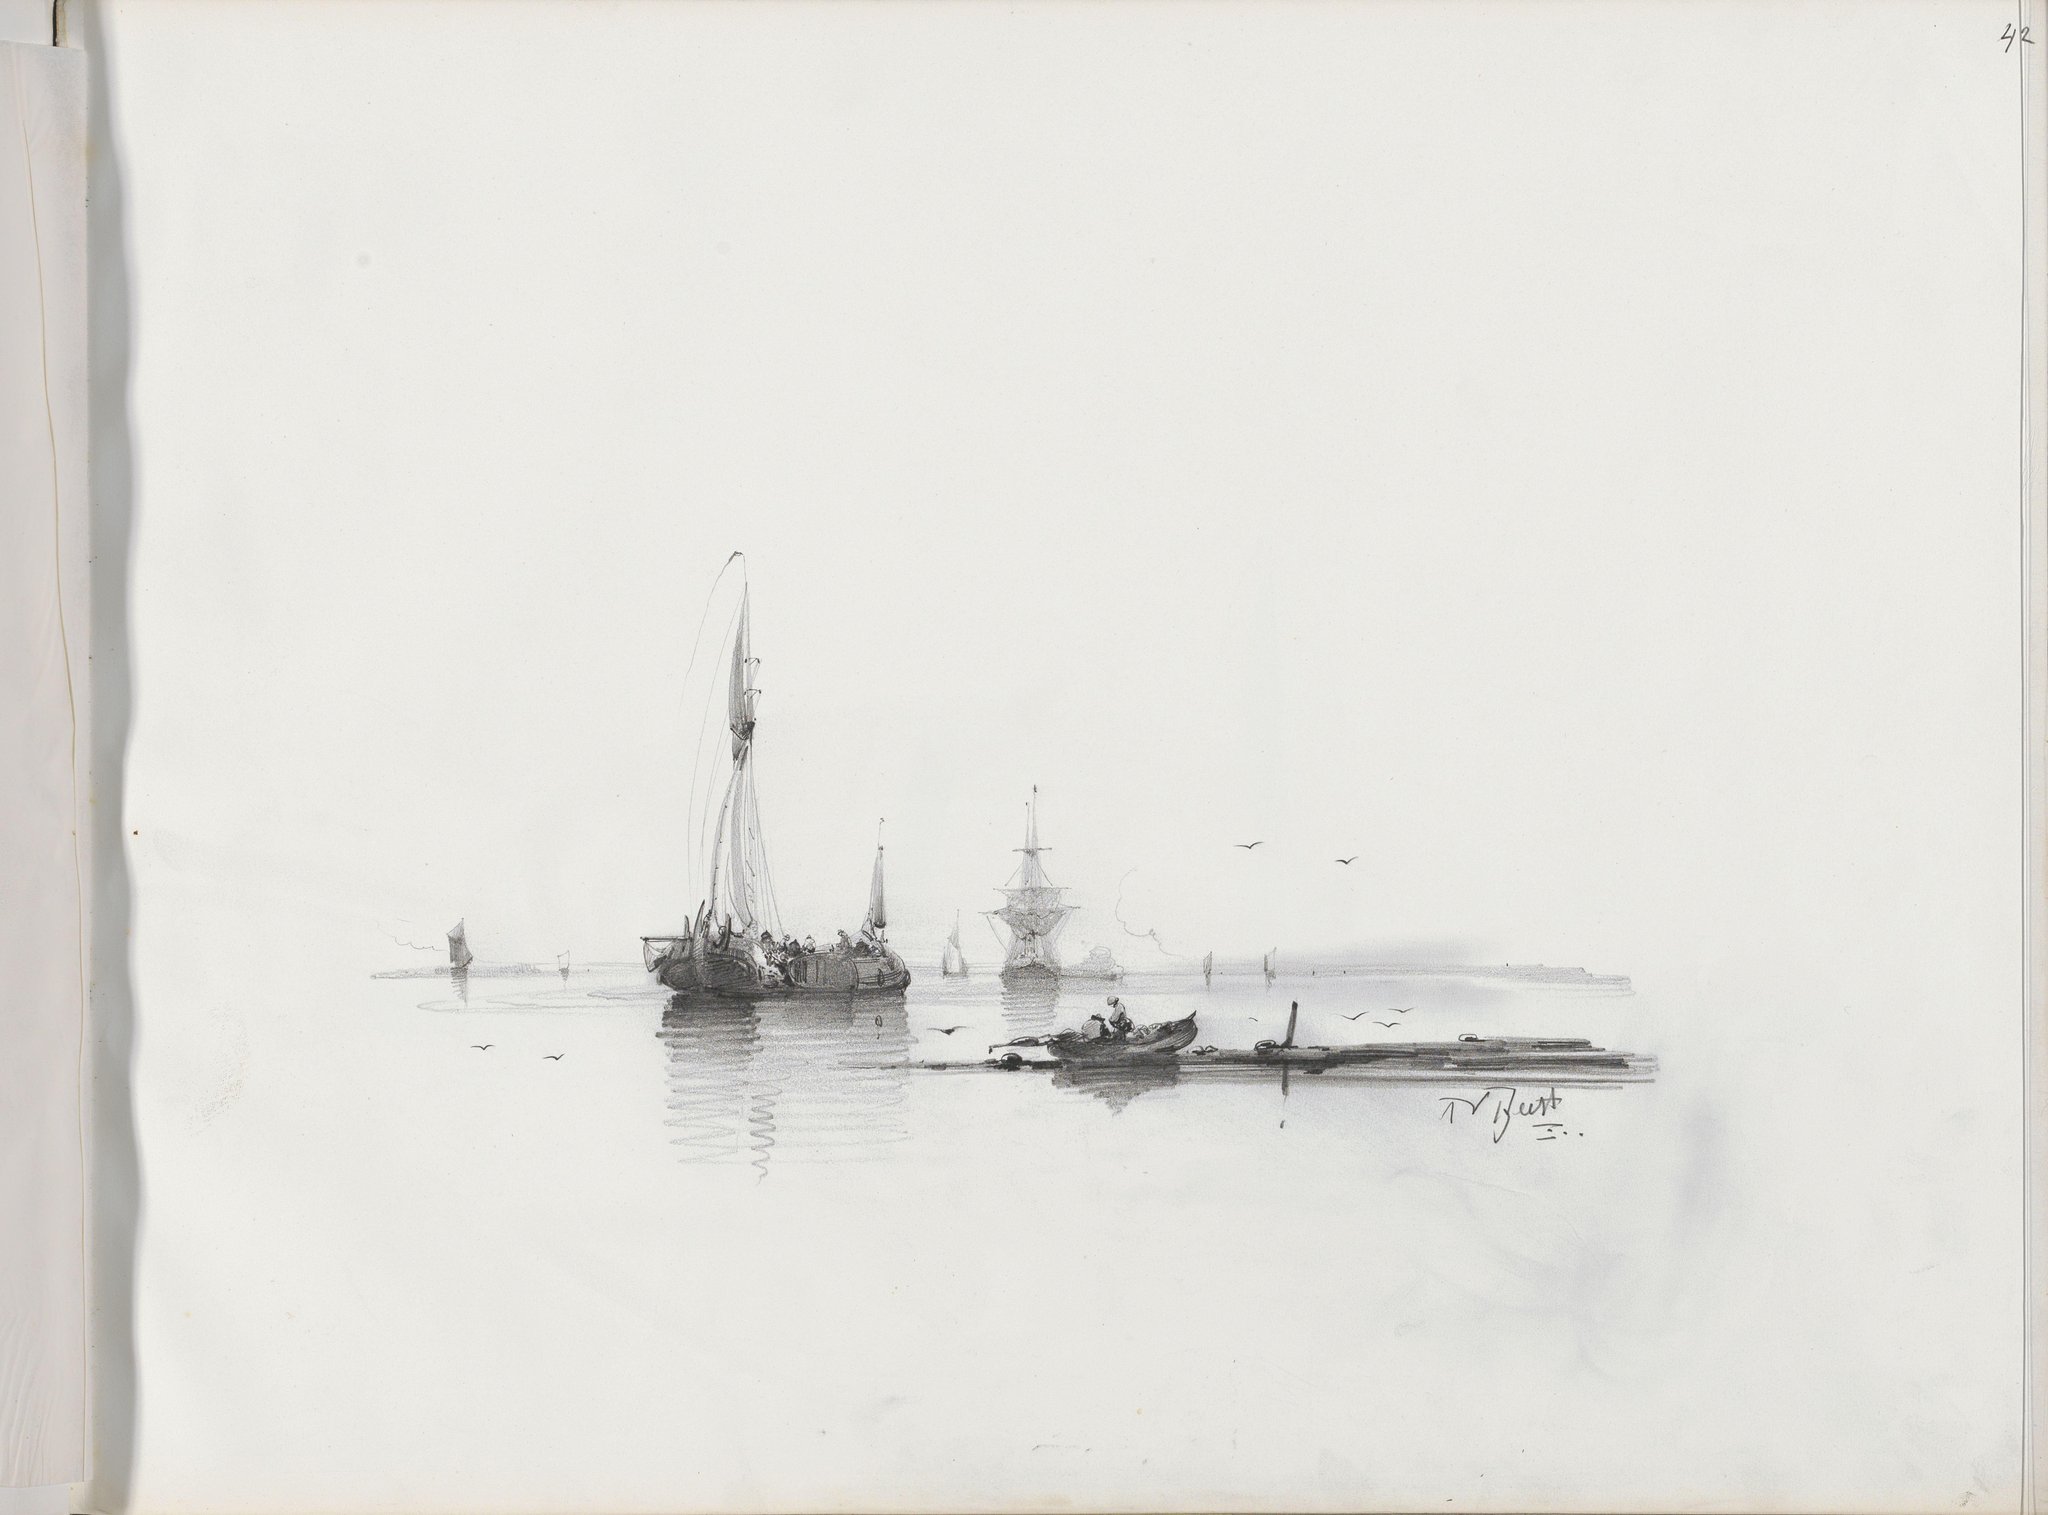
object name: sketchbook leaf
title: Afgemeerde zeilschepen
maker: albertus van beest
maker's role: draughtsman, print maker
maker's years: 1820-1860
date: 1830-1860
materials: paper, pencil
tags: sailing-ship, sailing-boat, landscapes with waters, waterscapes, seascapes (in the temperate zone)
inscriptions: signature: ‘A V Beest’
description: Op de voorgrond twee figuren in een vissersboot. Blad 42 recto uit een schetsboek met 46 bladen.